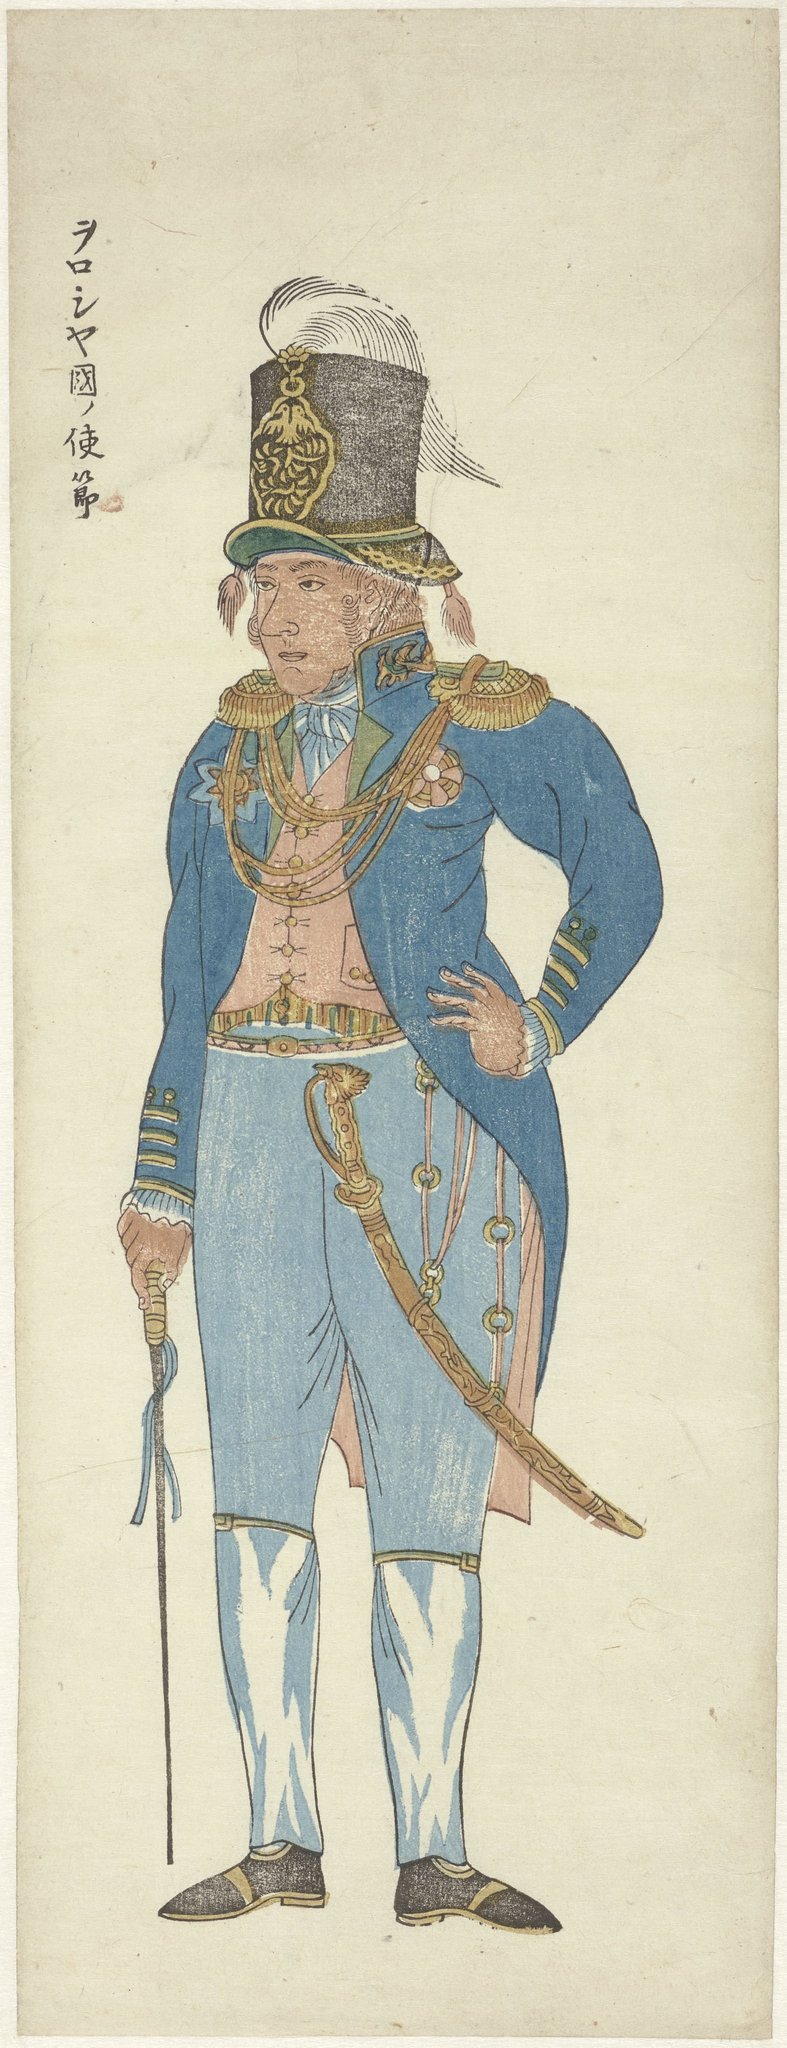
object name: print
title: Woroshiyakoku no shisetsu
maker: Anonymous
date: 1740-1864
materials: paper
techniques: woodcut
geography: nagasaki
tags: europeans (with name)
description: Man met hoge hoed met pluim en sabel. (Nagasaki-e).